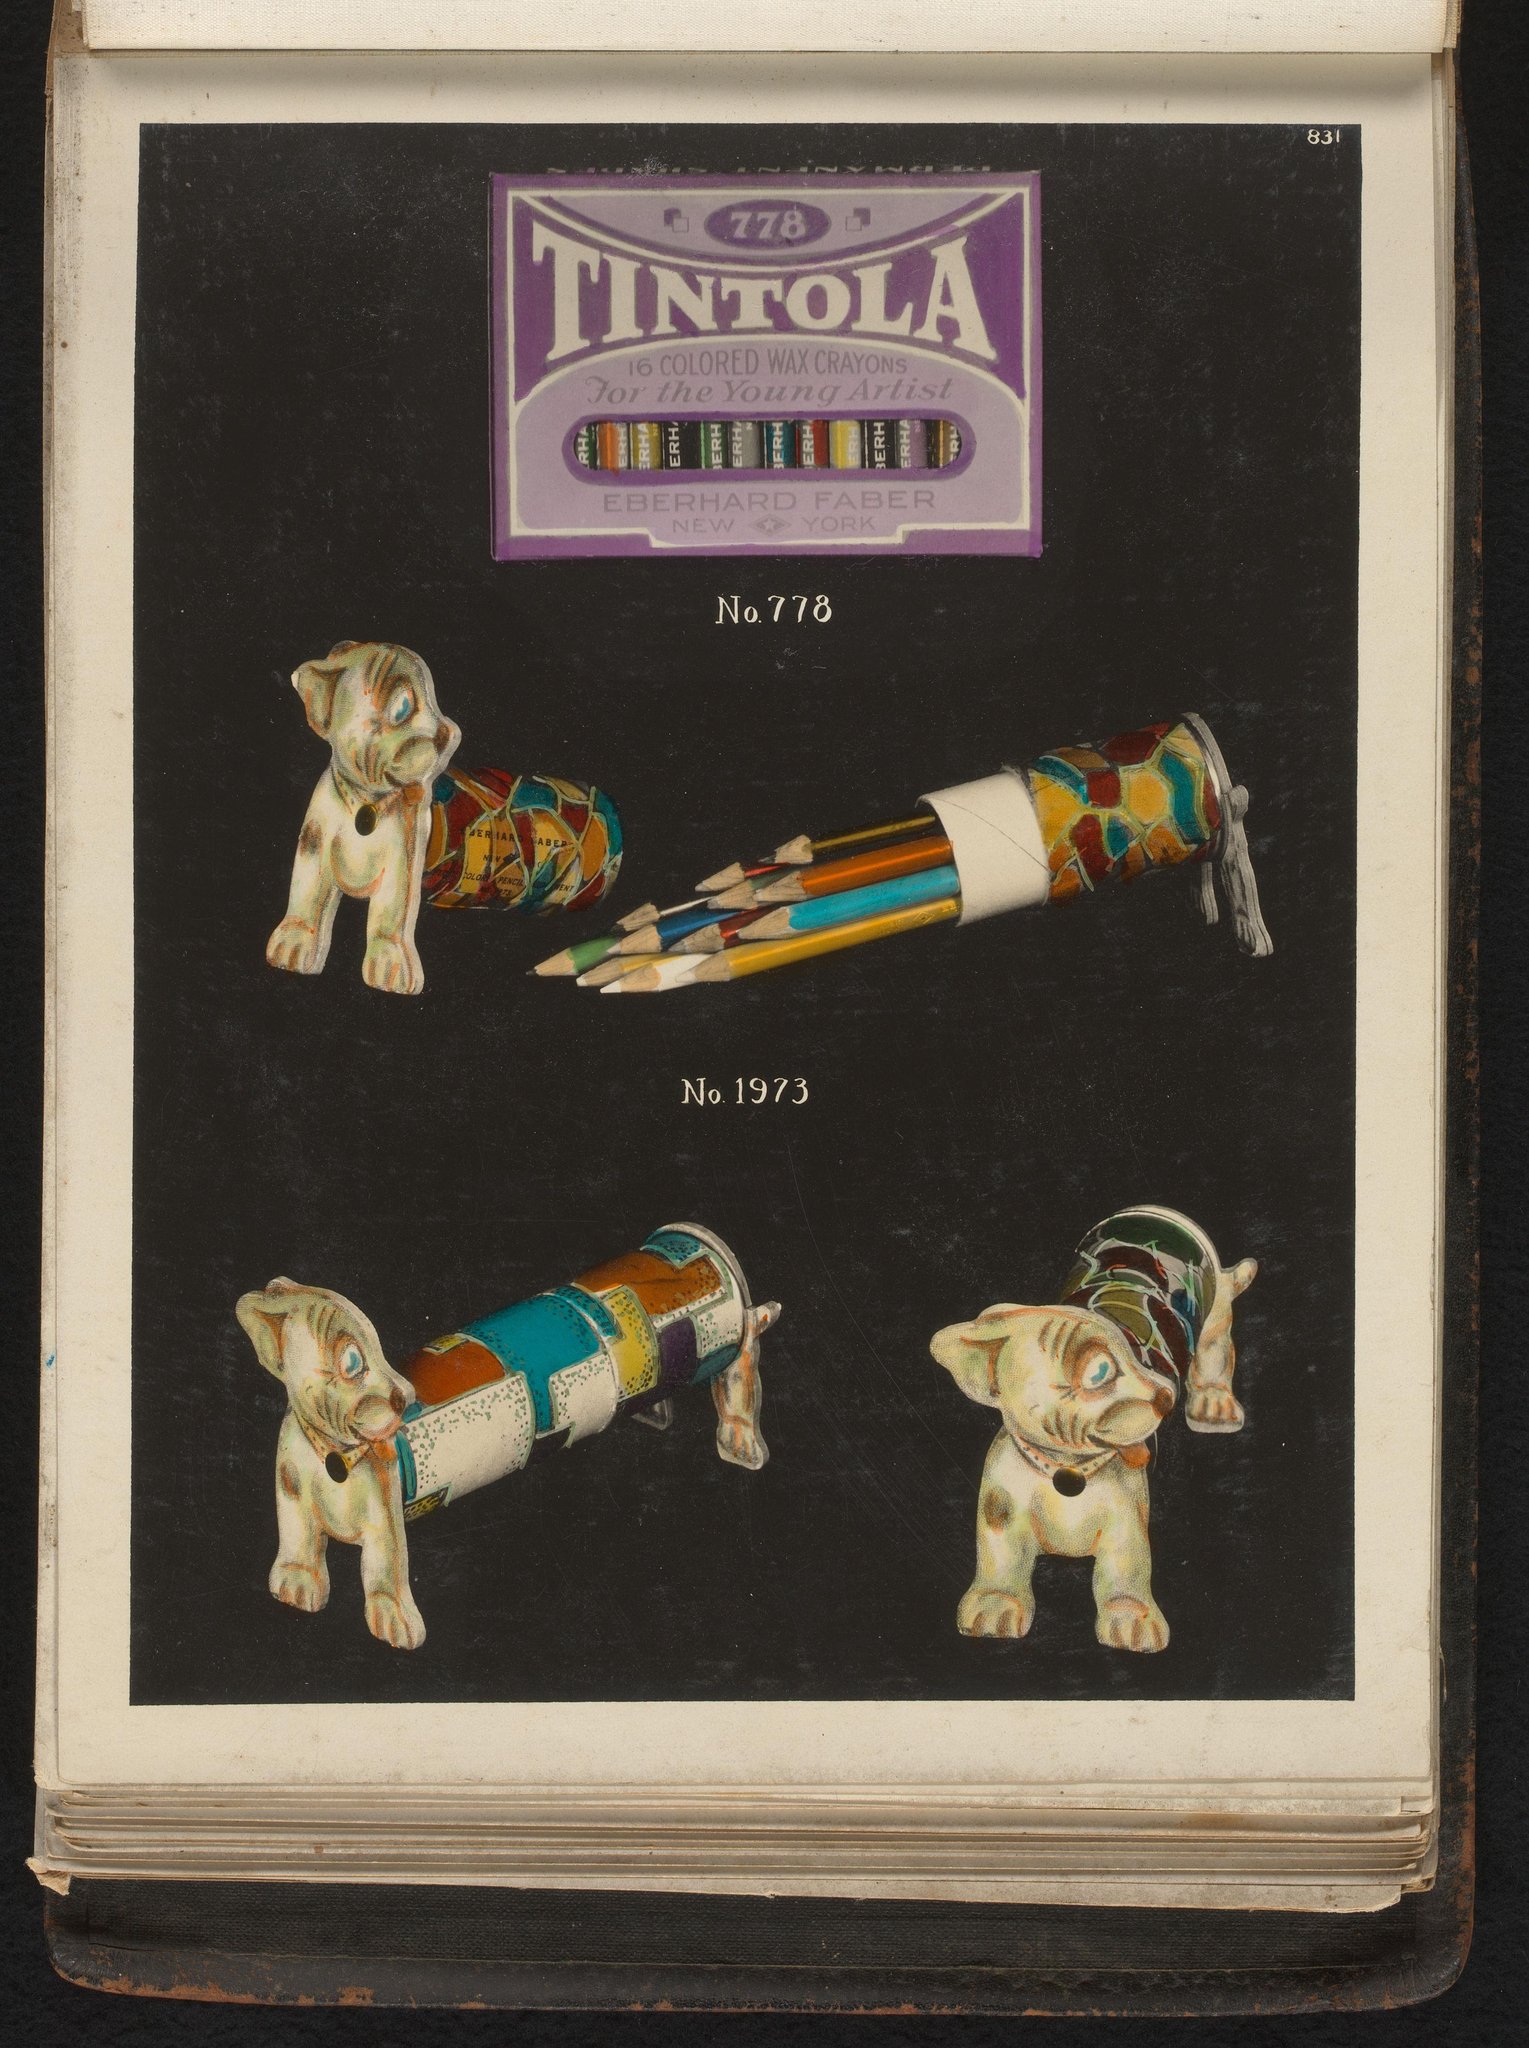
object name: photograph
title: Sets met kleurpotloden van Eberhard Faber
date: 1915-1935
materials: paper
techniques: gelatin silver print, hand coloring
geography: springfield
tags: pencil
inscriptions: stamp: ‘Paramount/ Commercial Studios/ 145 Chestnut St./ Springfield - Mass.’, number: ‘831’